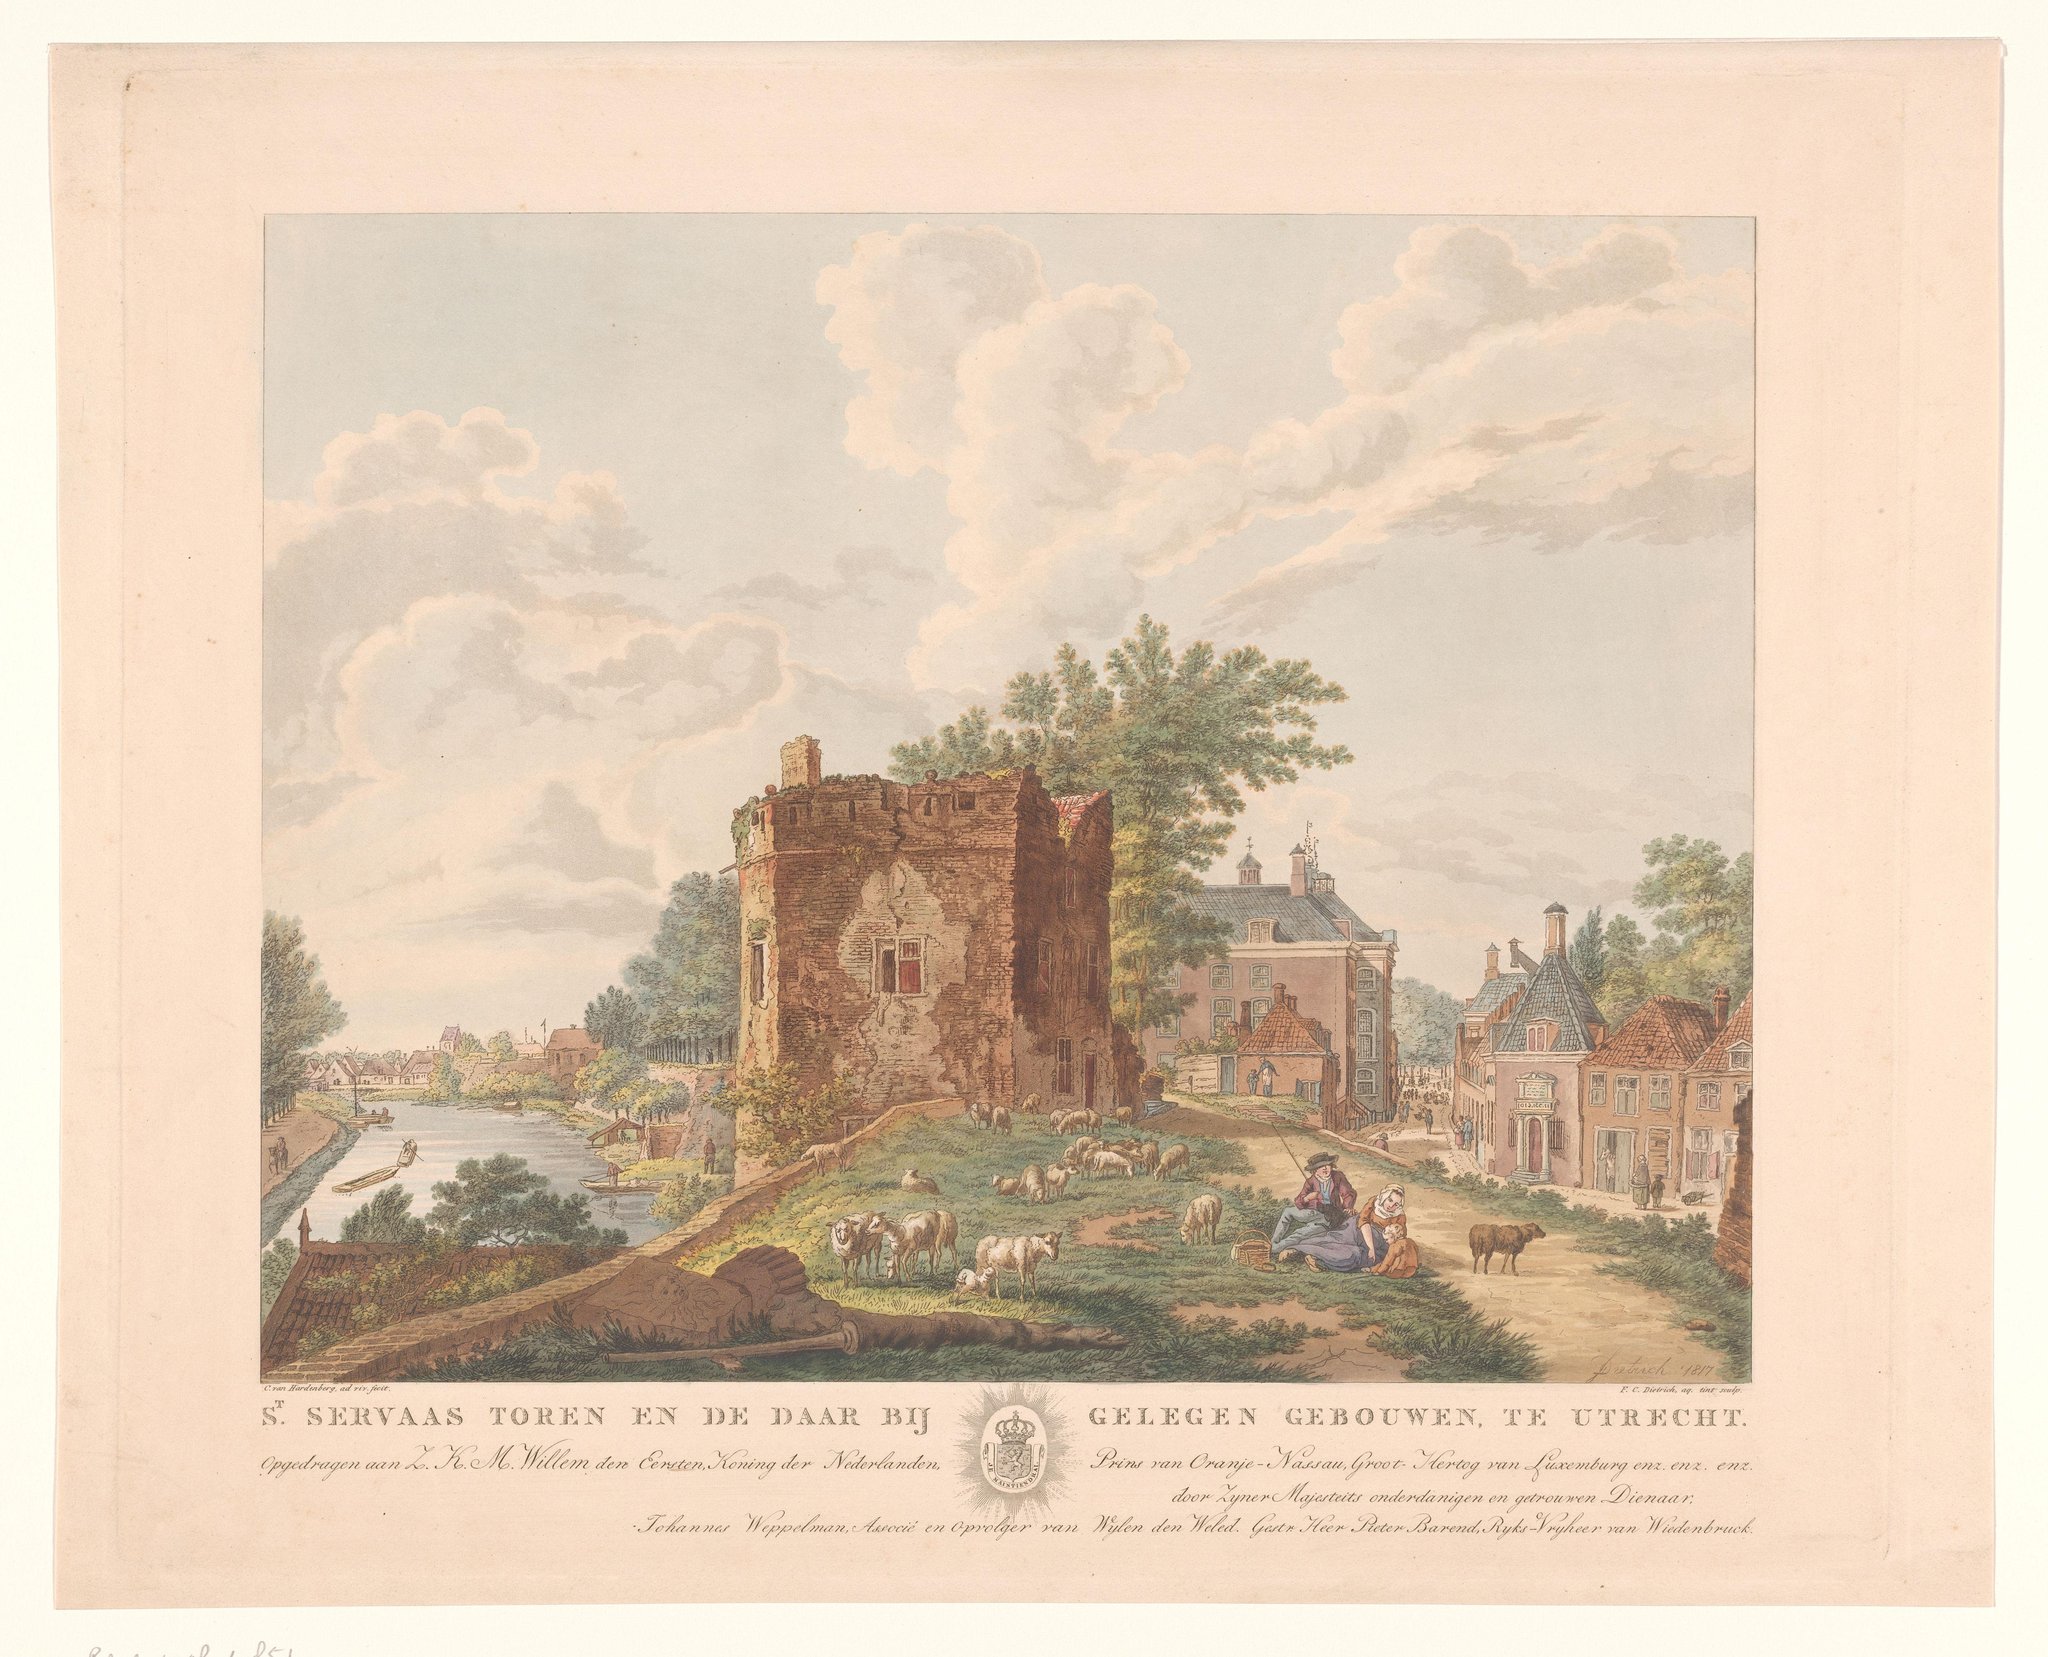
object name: print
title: Gezicht op de Sint Servaastoren te Utrecht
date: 1817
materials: paper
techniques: aquatint, etching, hand coloring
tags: city-view, and landscape with man-made constructions, armorial bearing, heraldry, utrecht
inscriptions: collector's mark: Lugt 2228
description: Prent maakt deel uit van de uitgave: Johannes Weppelman, Verzameling van bouw- en beeldhouwkunst, en vele verdere zeldzaamheden ..., Utrecht (W.F. Stamrood) 1817